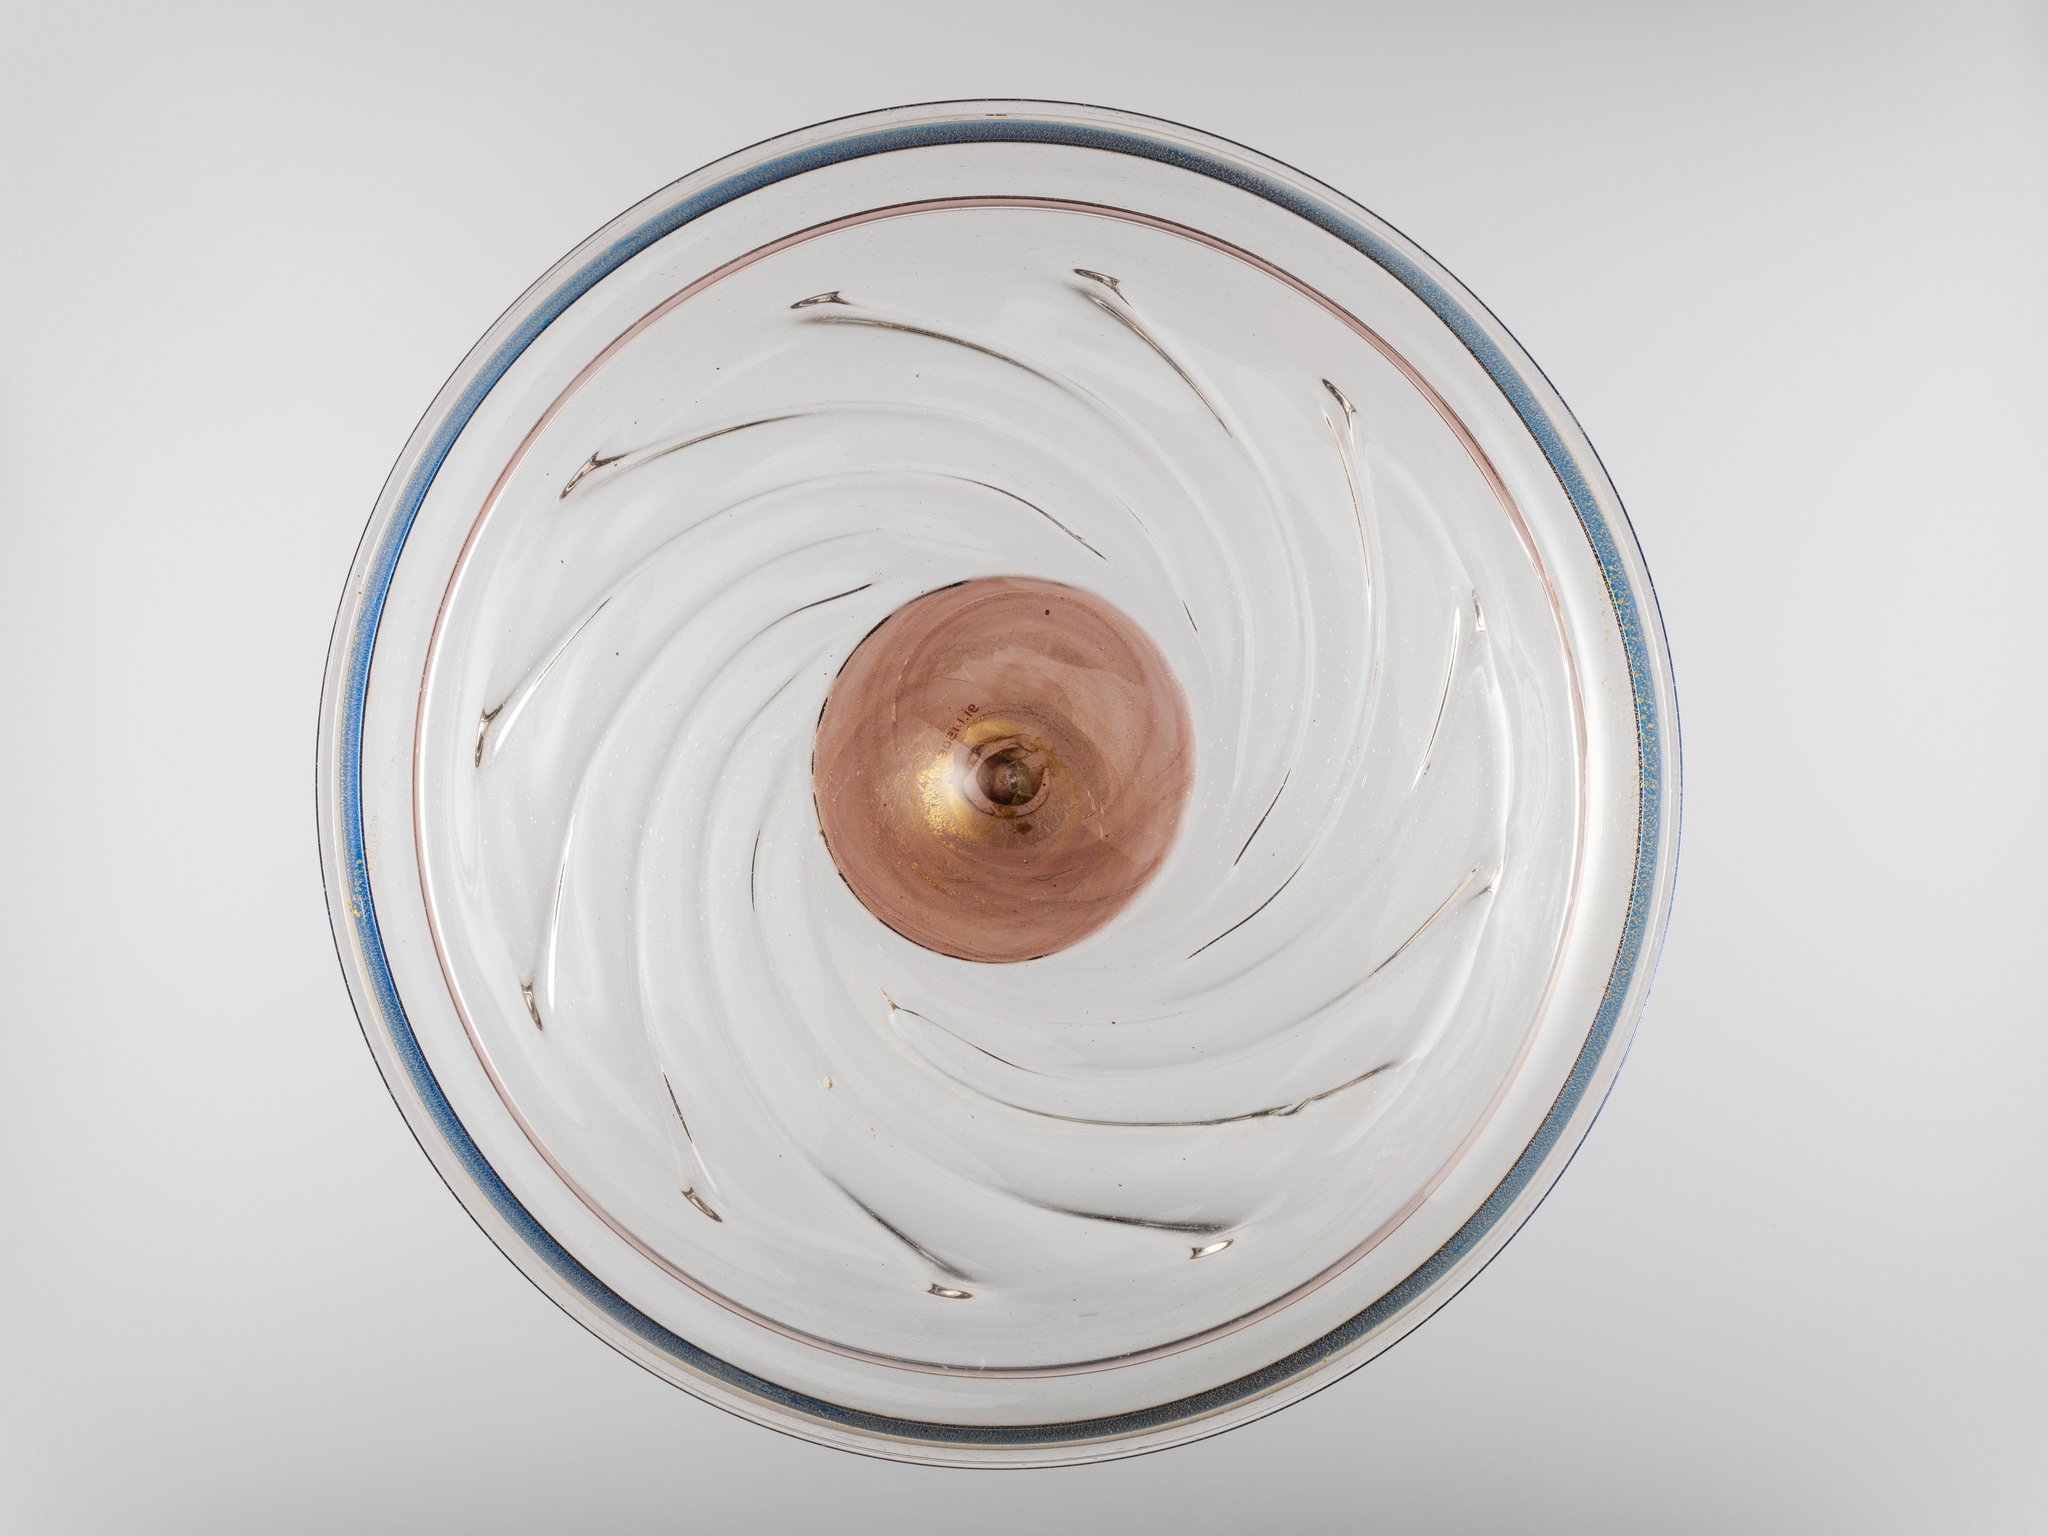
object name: plateau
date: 1801-1900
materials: gilt, glass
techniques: enamel